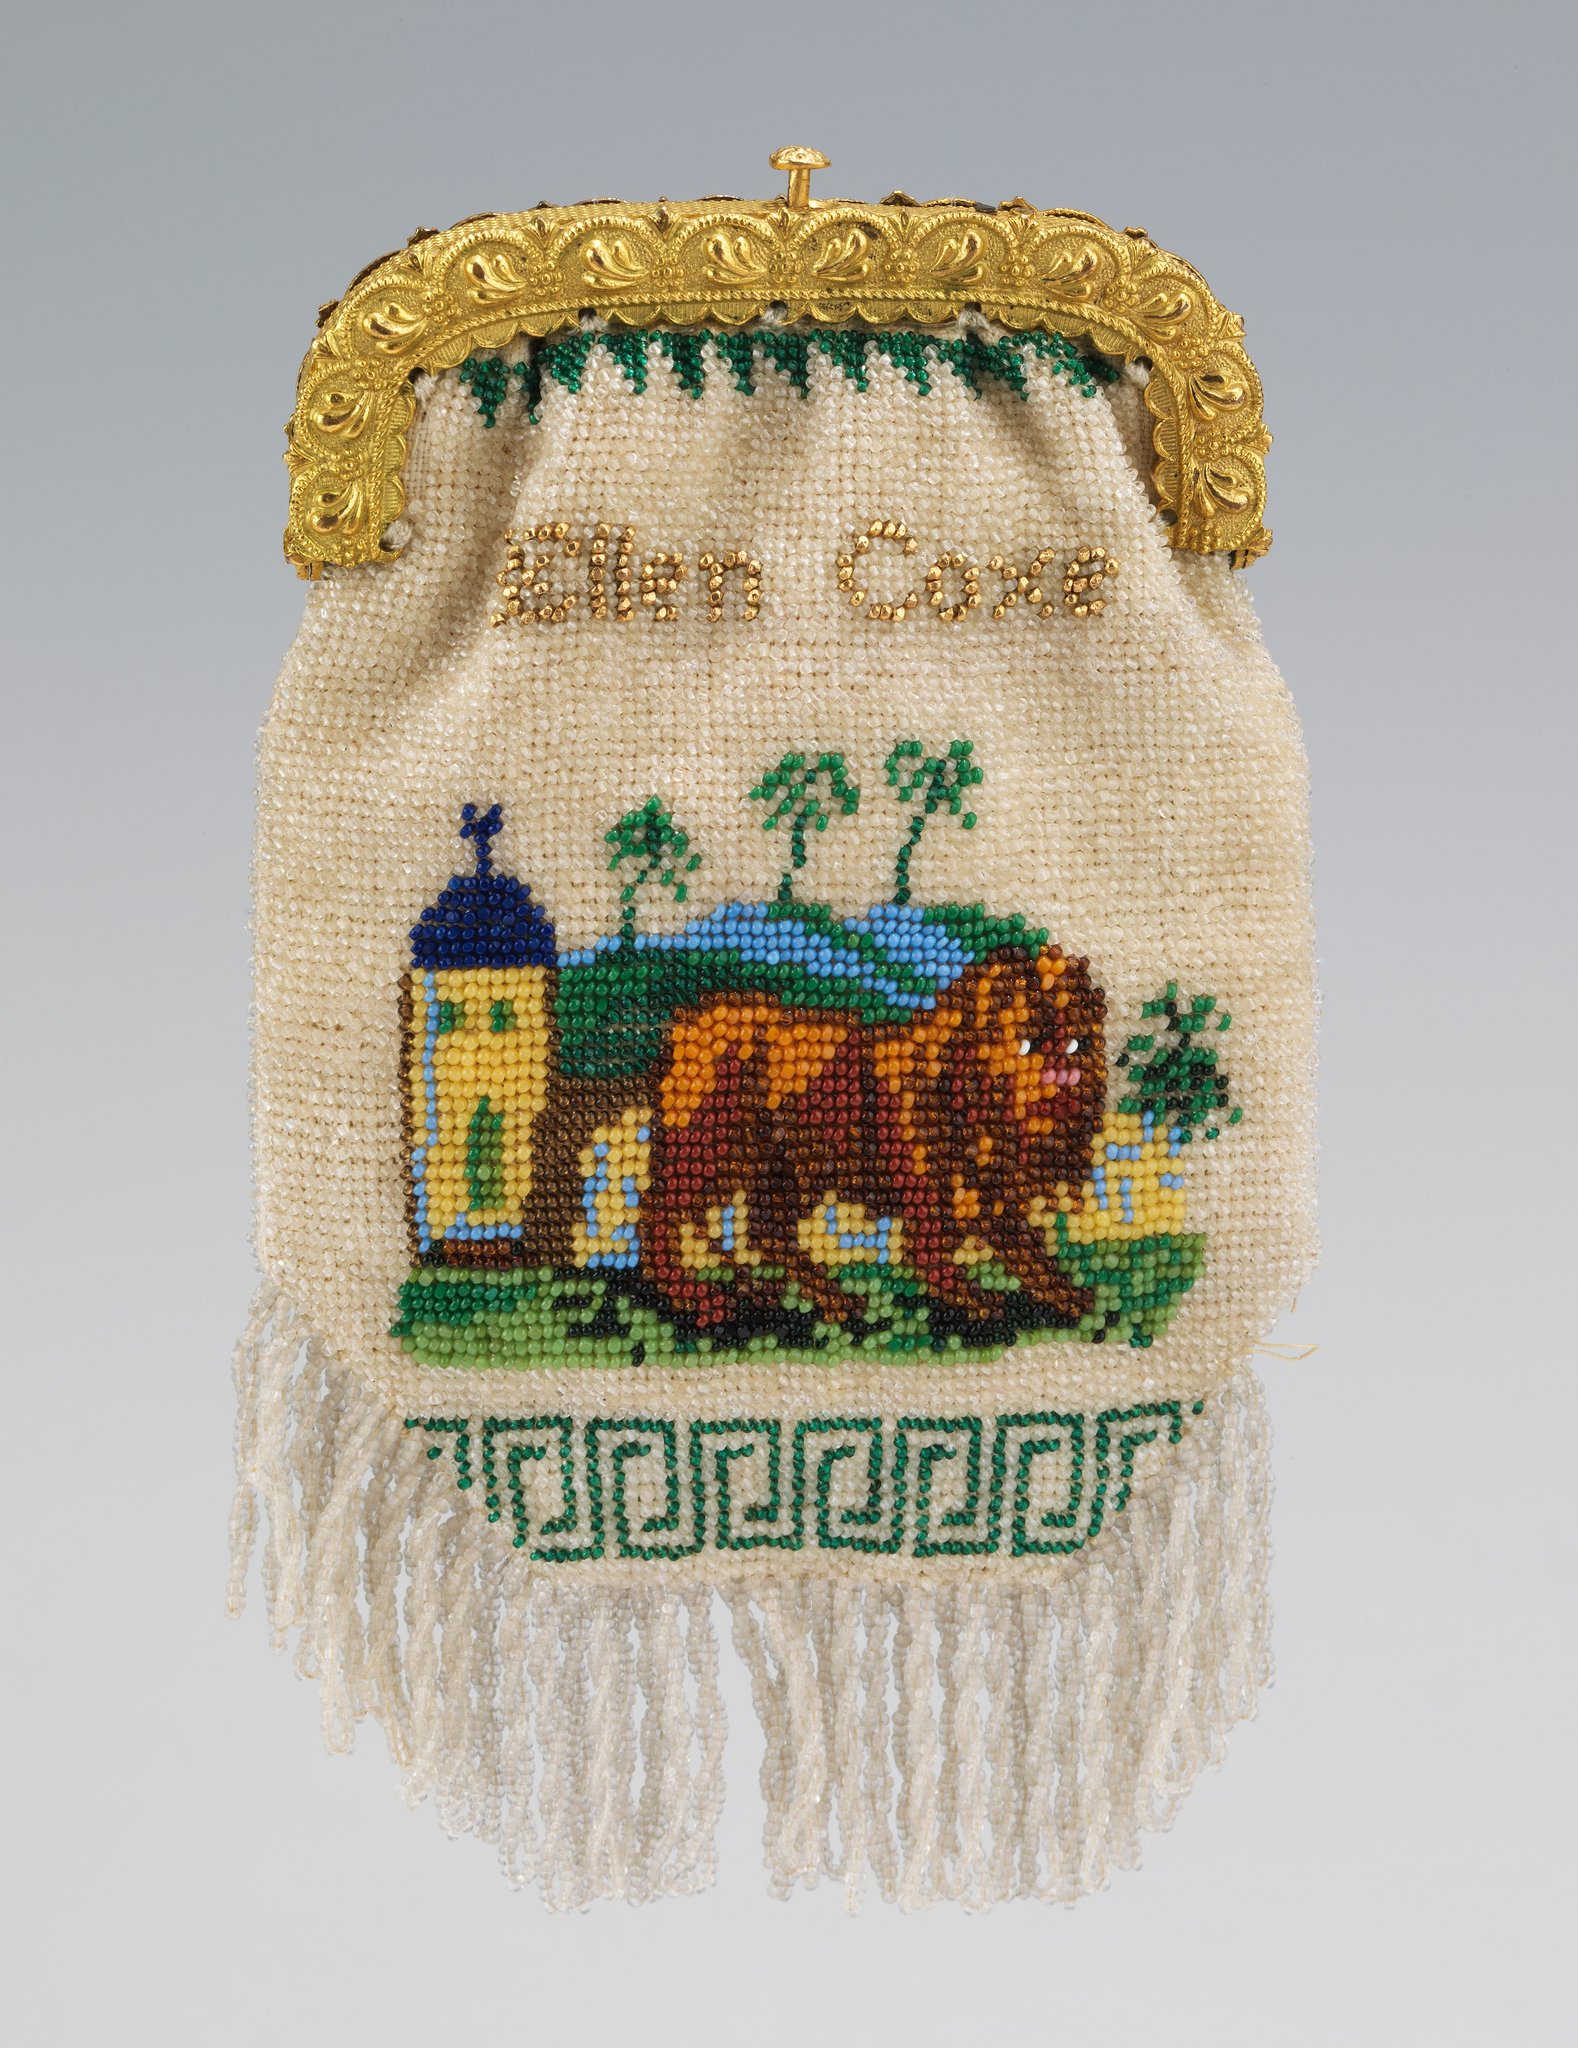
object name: bag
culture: american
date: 1838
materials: glass, linen, metal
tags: lions